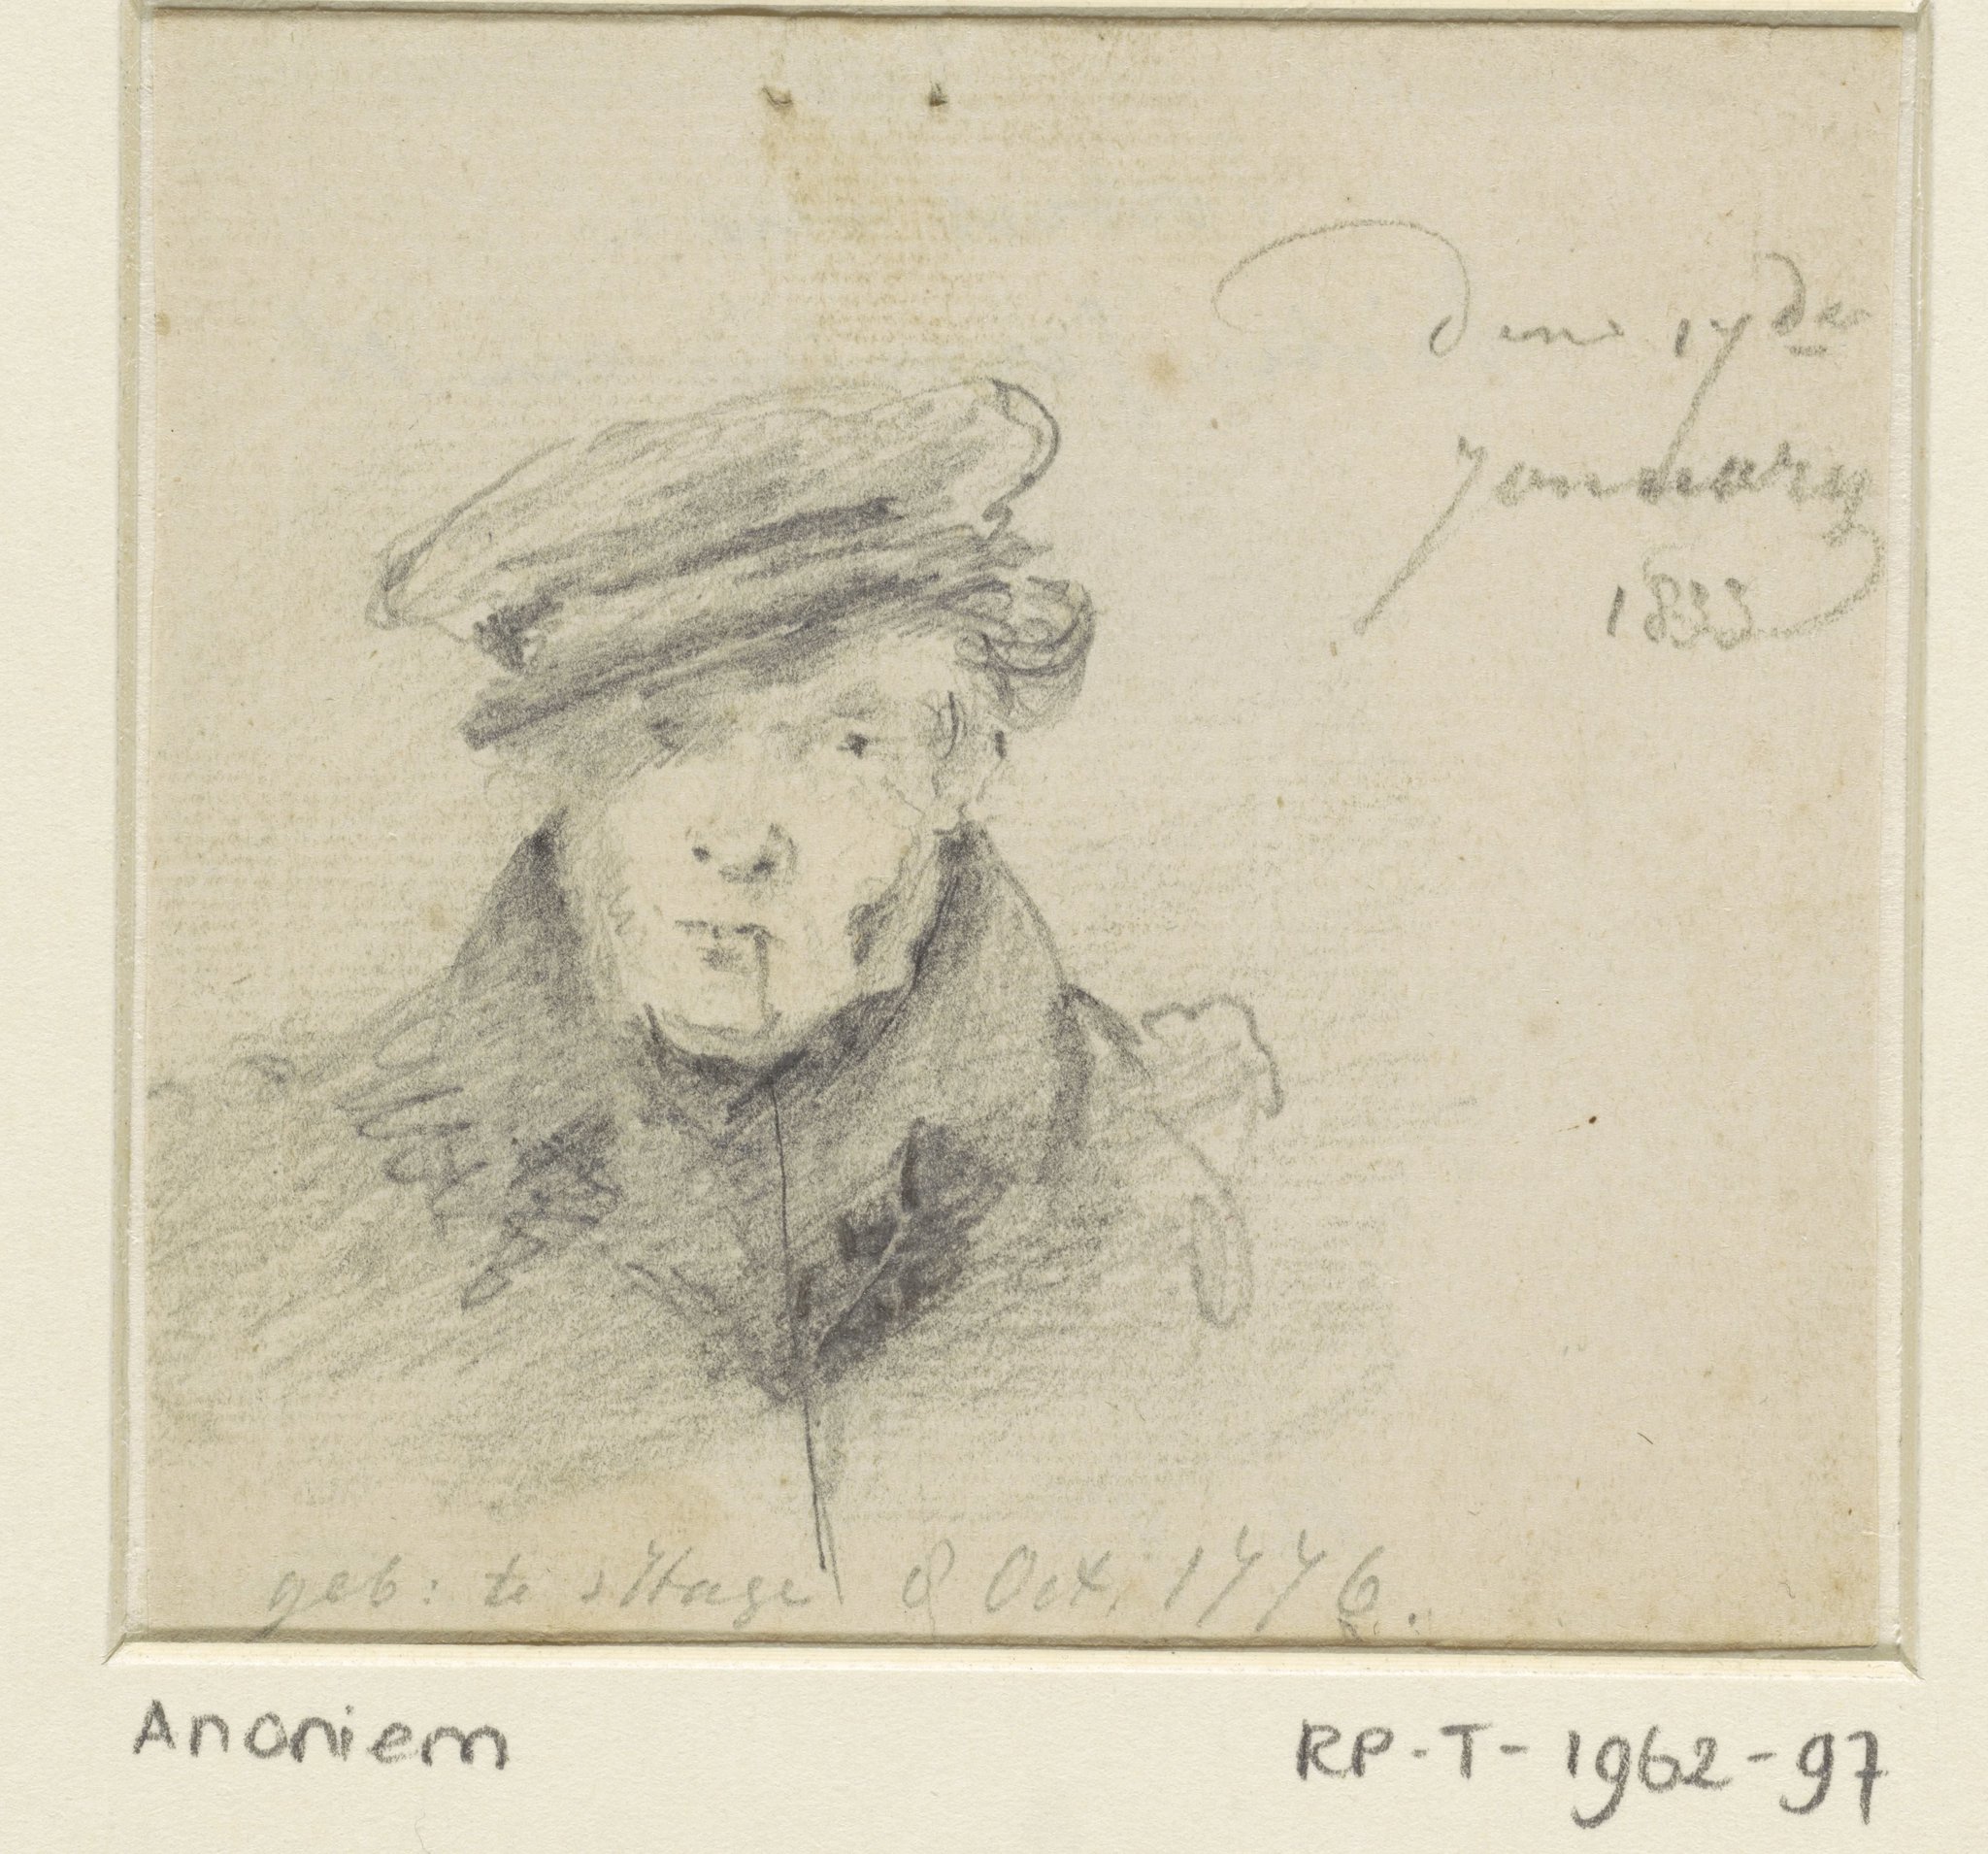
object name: drawing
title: Portret van Pieter Gerardus van Os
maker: Anonymous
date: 1786-1889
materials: paper, pencil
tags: the hague, painter, print maker, draughtsman, pieter gerardus van os, historical persons, portrait, self-portrait of artist